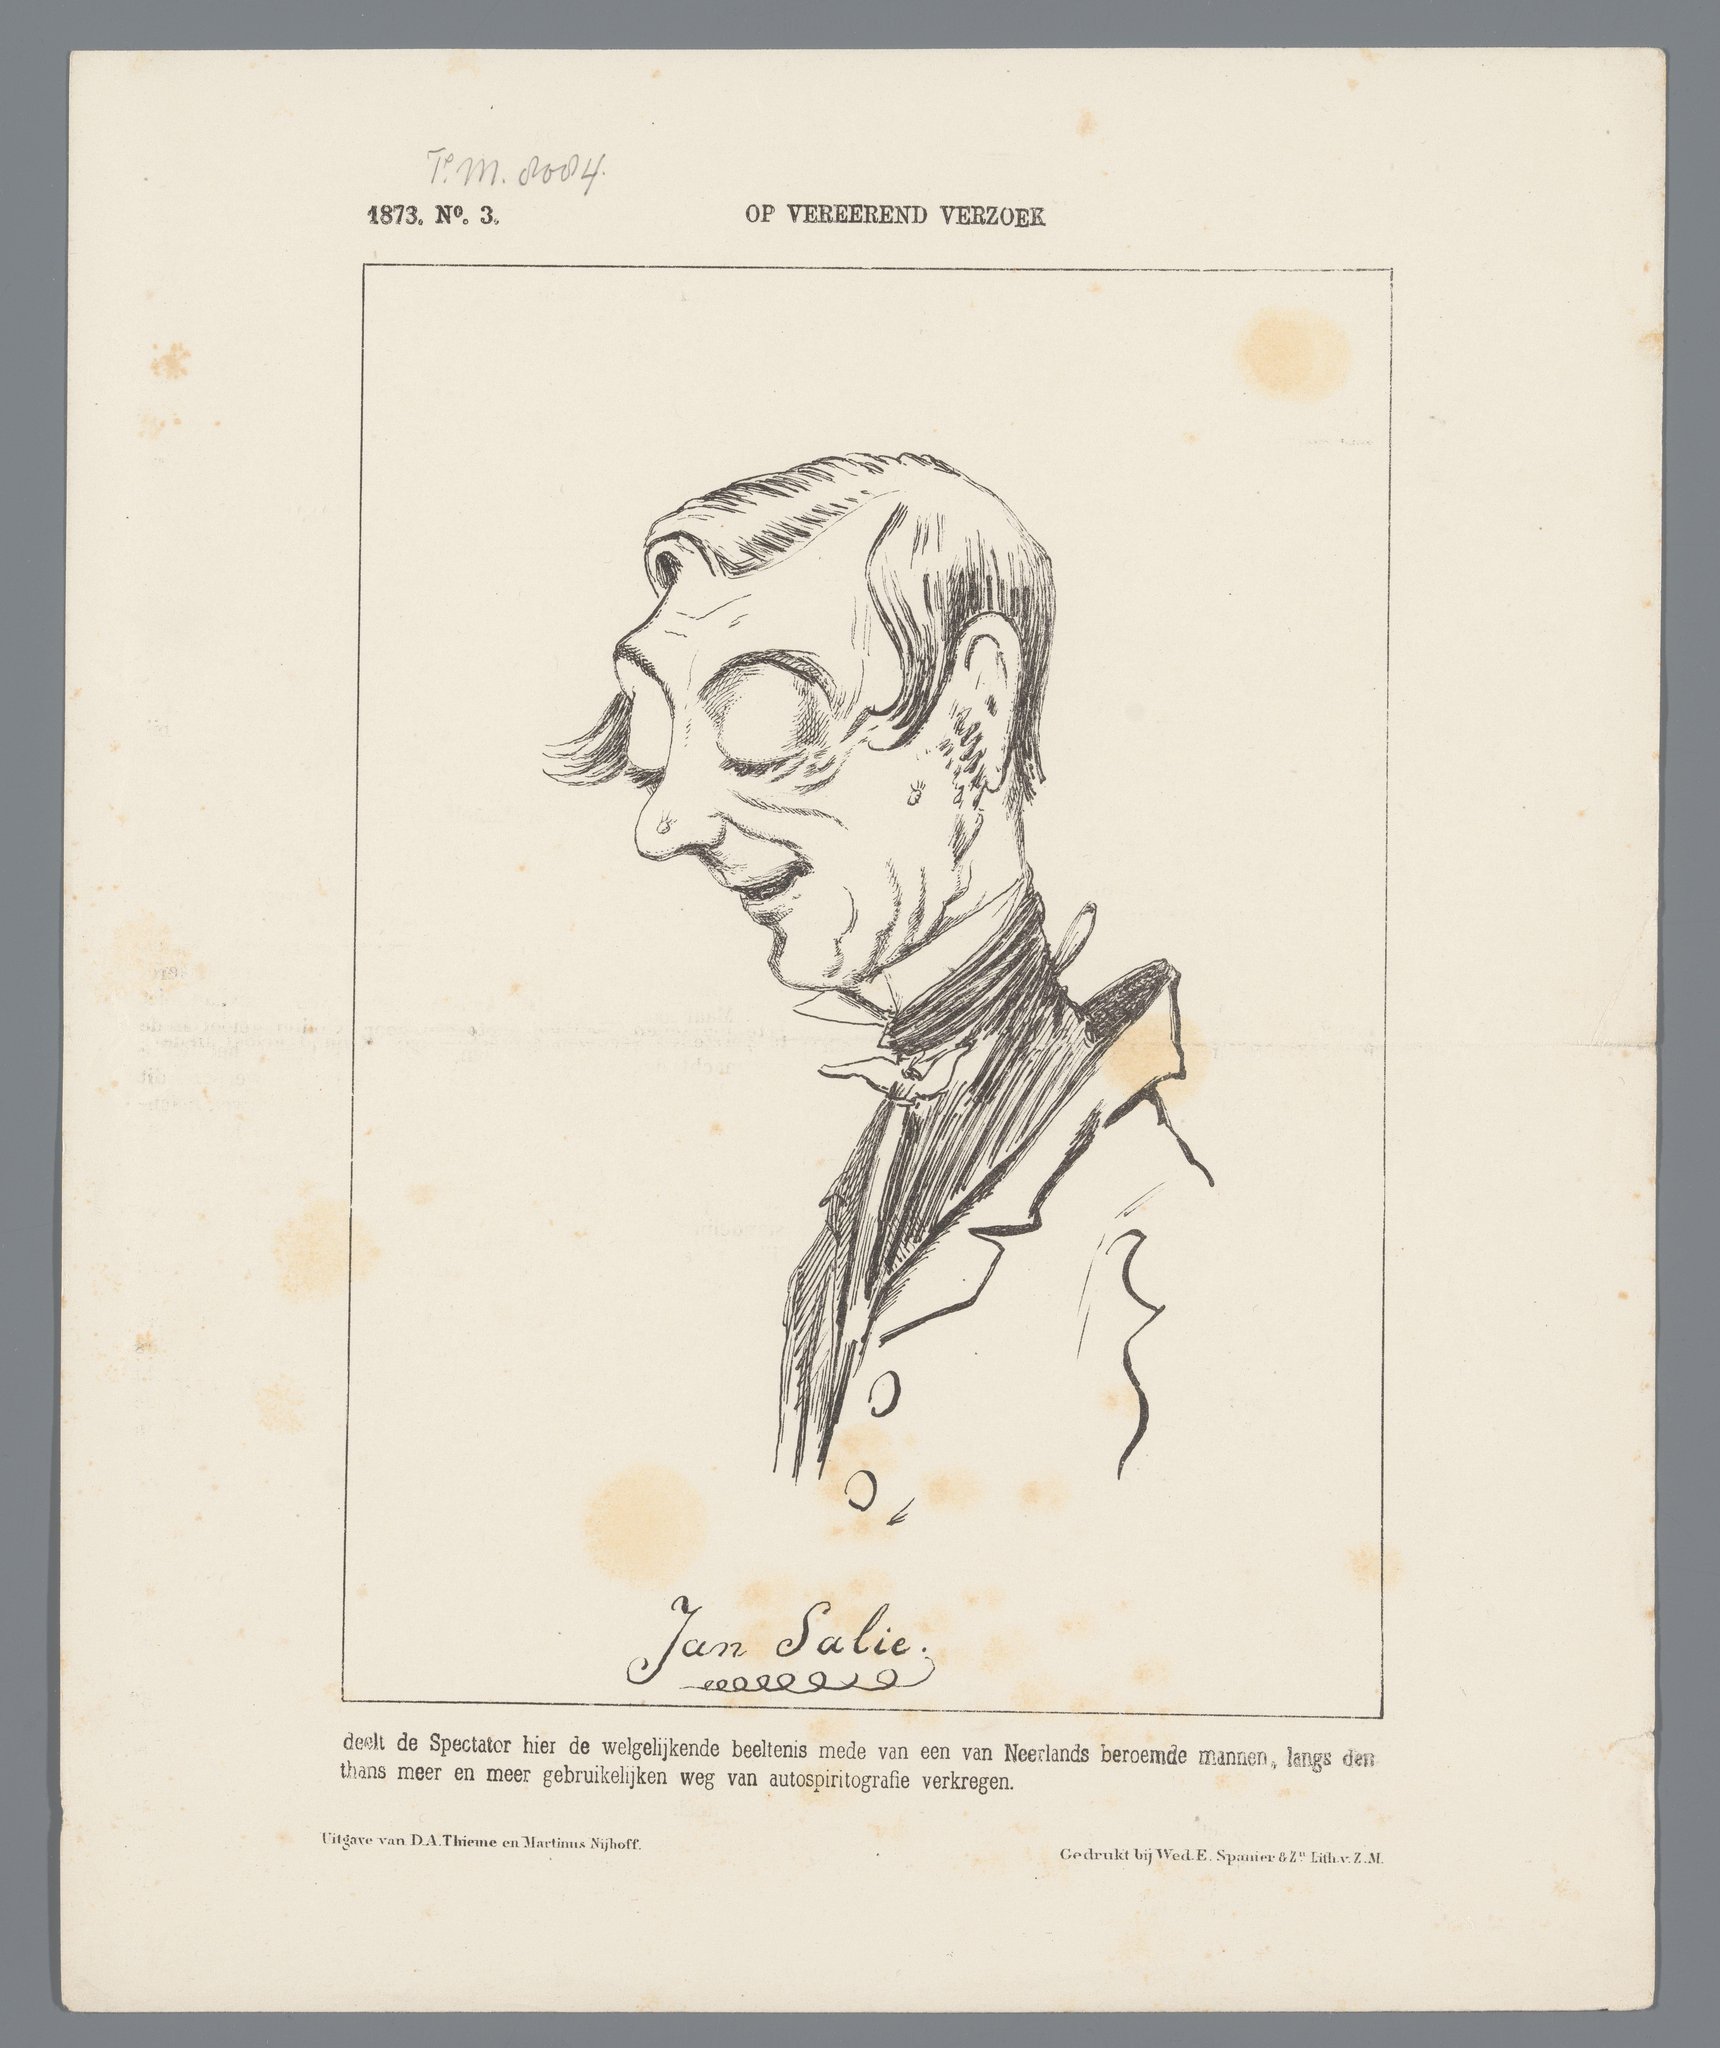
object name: print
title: Op vereerend verzoek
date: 1873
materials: paper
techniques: lithograph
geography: netherlands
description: Spotprent met gefingeerd portret van Jan Salie. Plaat verschenen bij het weekblad De Nederlandsche Spectator, nr. 3, 1873.